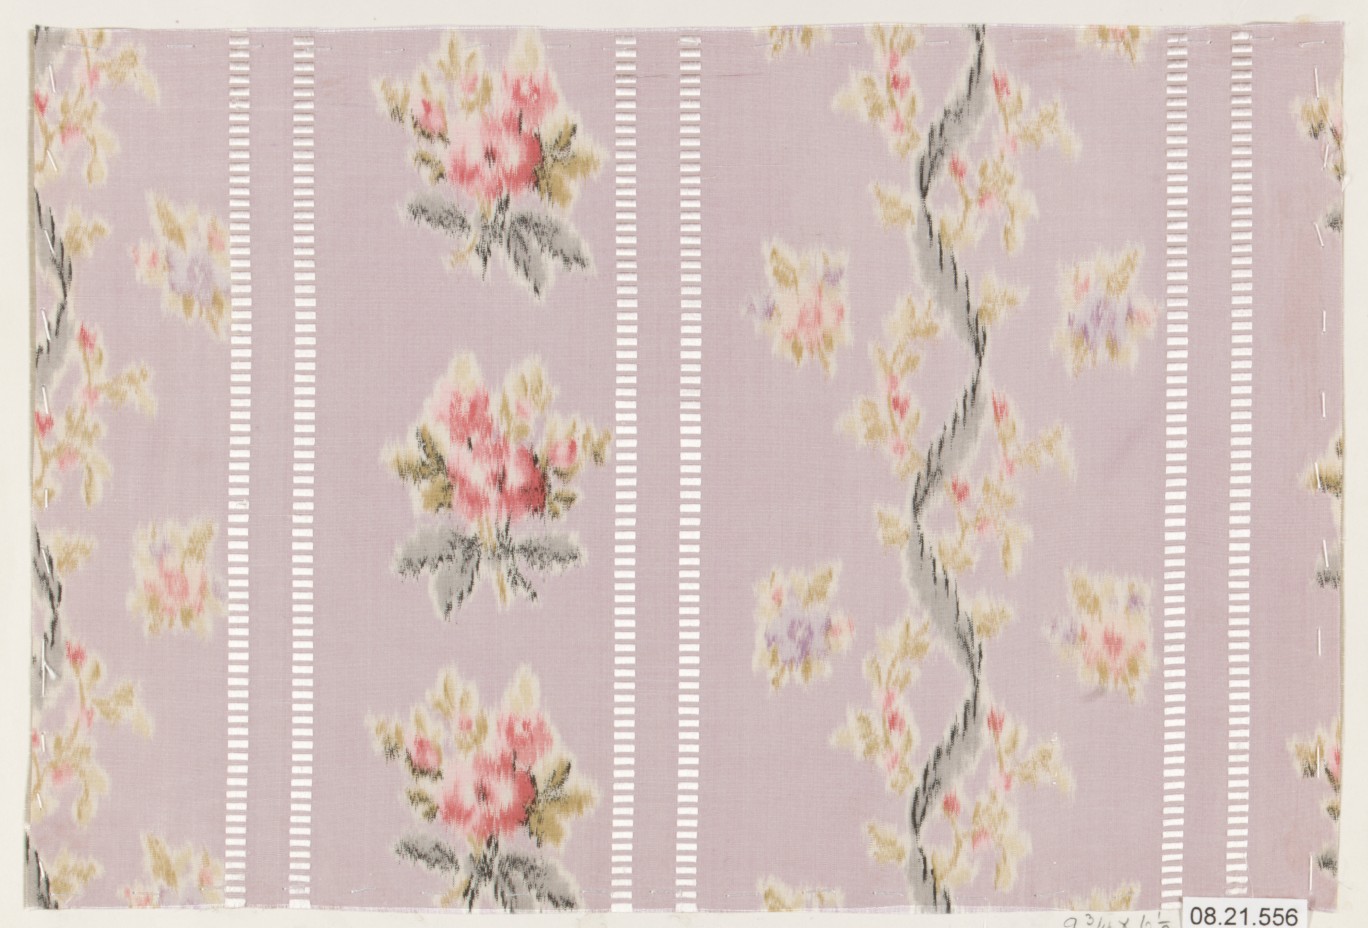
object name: textile sample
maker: Anonymous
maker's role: designer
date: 1900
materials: silk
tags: flowers